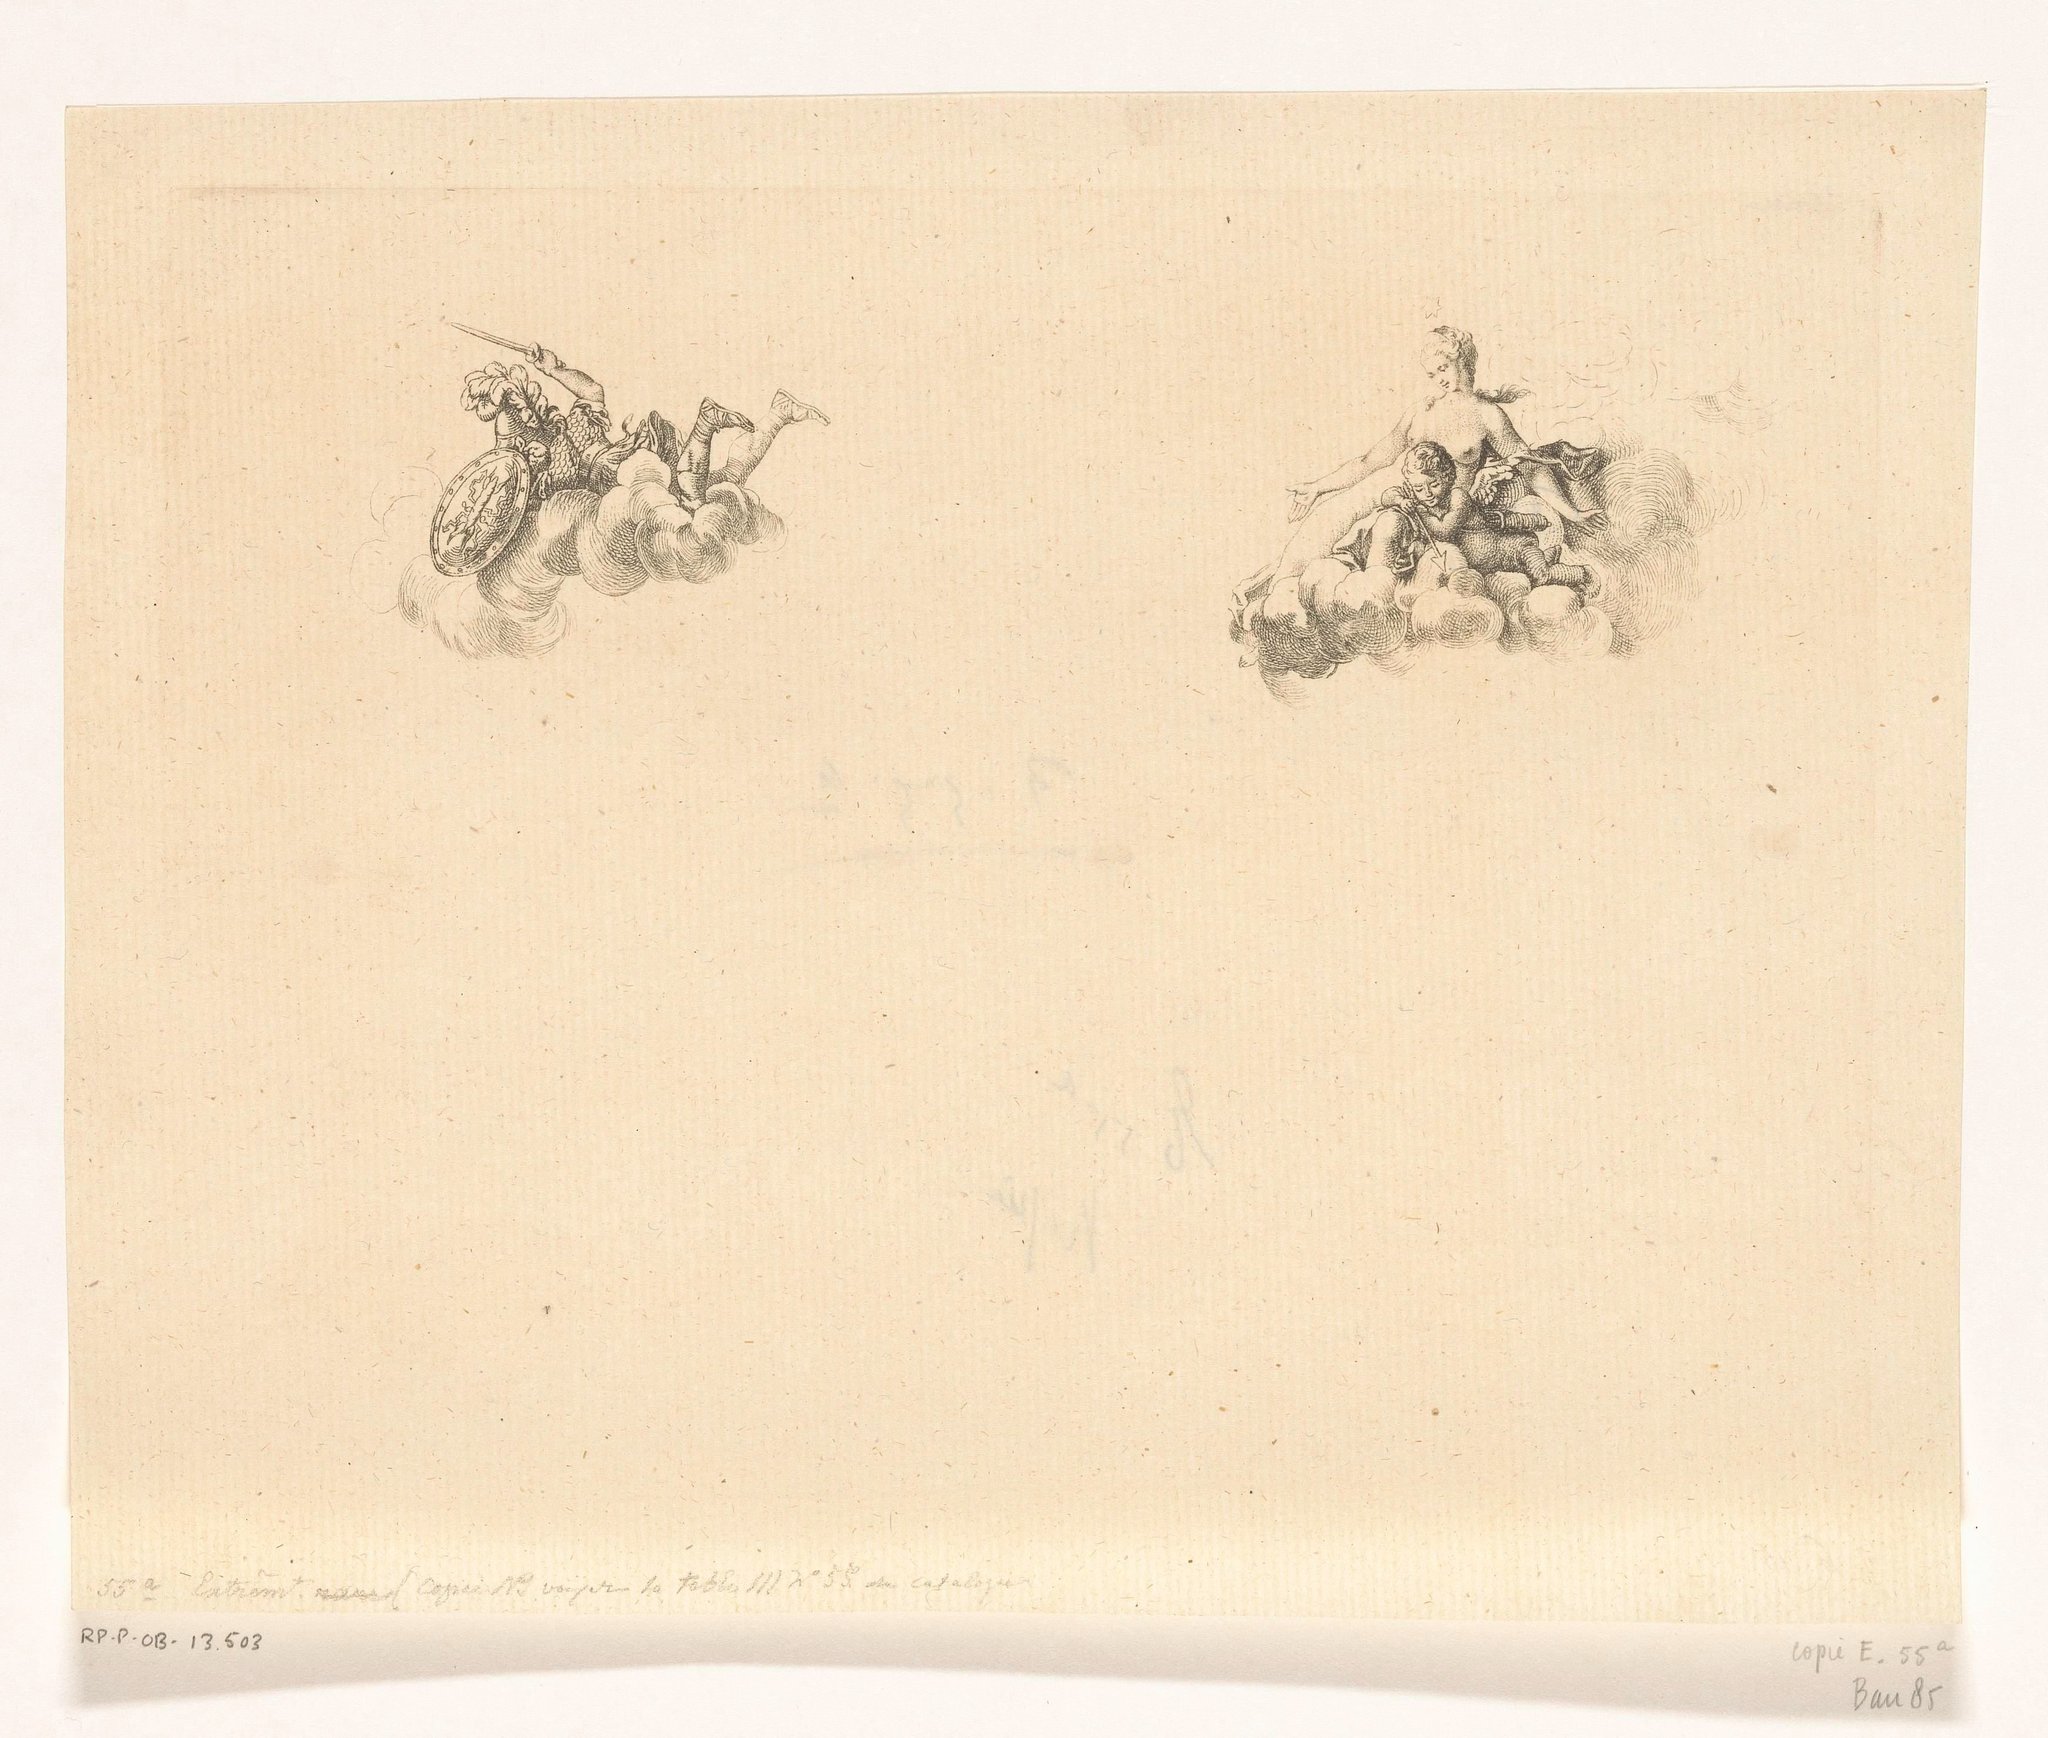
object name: print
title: Mars en Venus in de wolken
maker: Anonymous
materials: paper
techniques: etching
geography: germany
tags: (story of) mars (ares), specific aspects, allegorical aspects of venus; venus as patroness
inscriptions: collector's mark: Lugt 2228